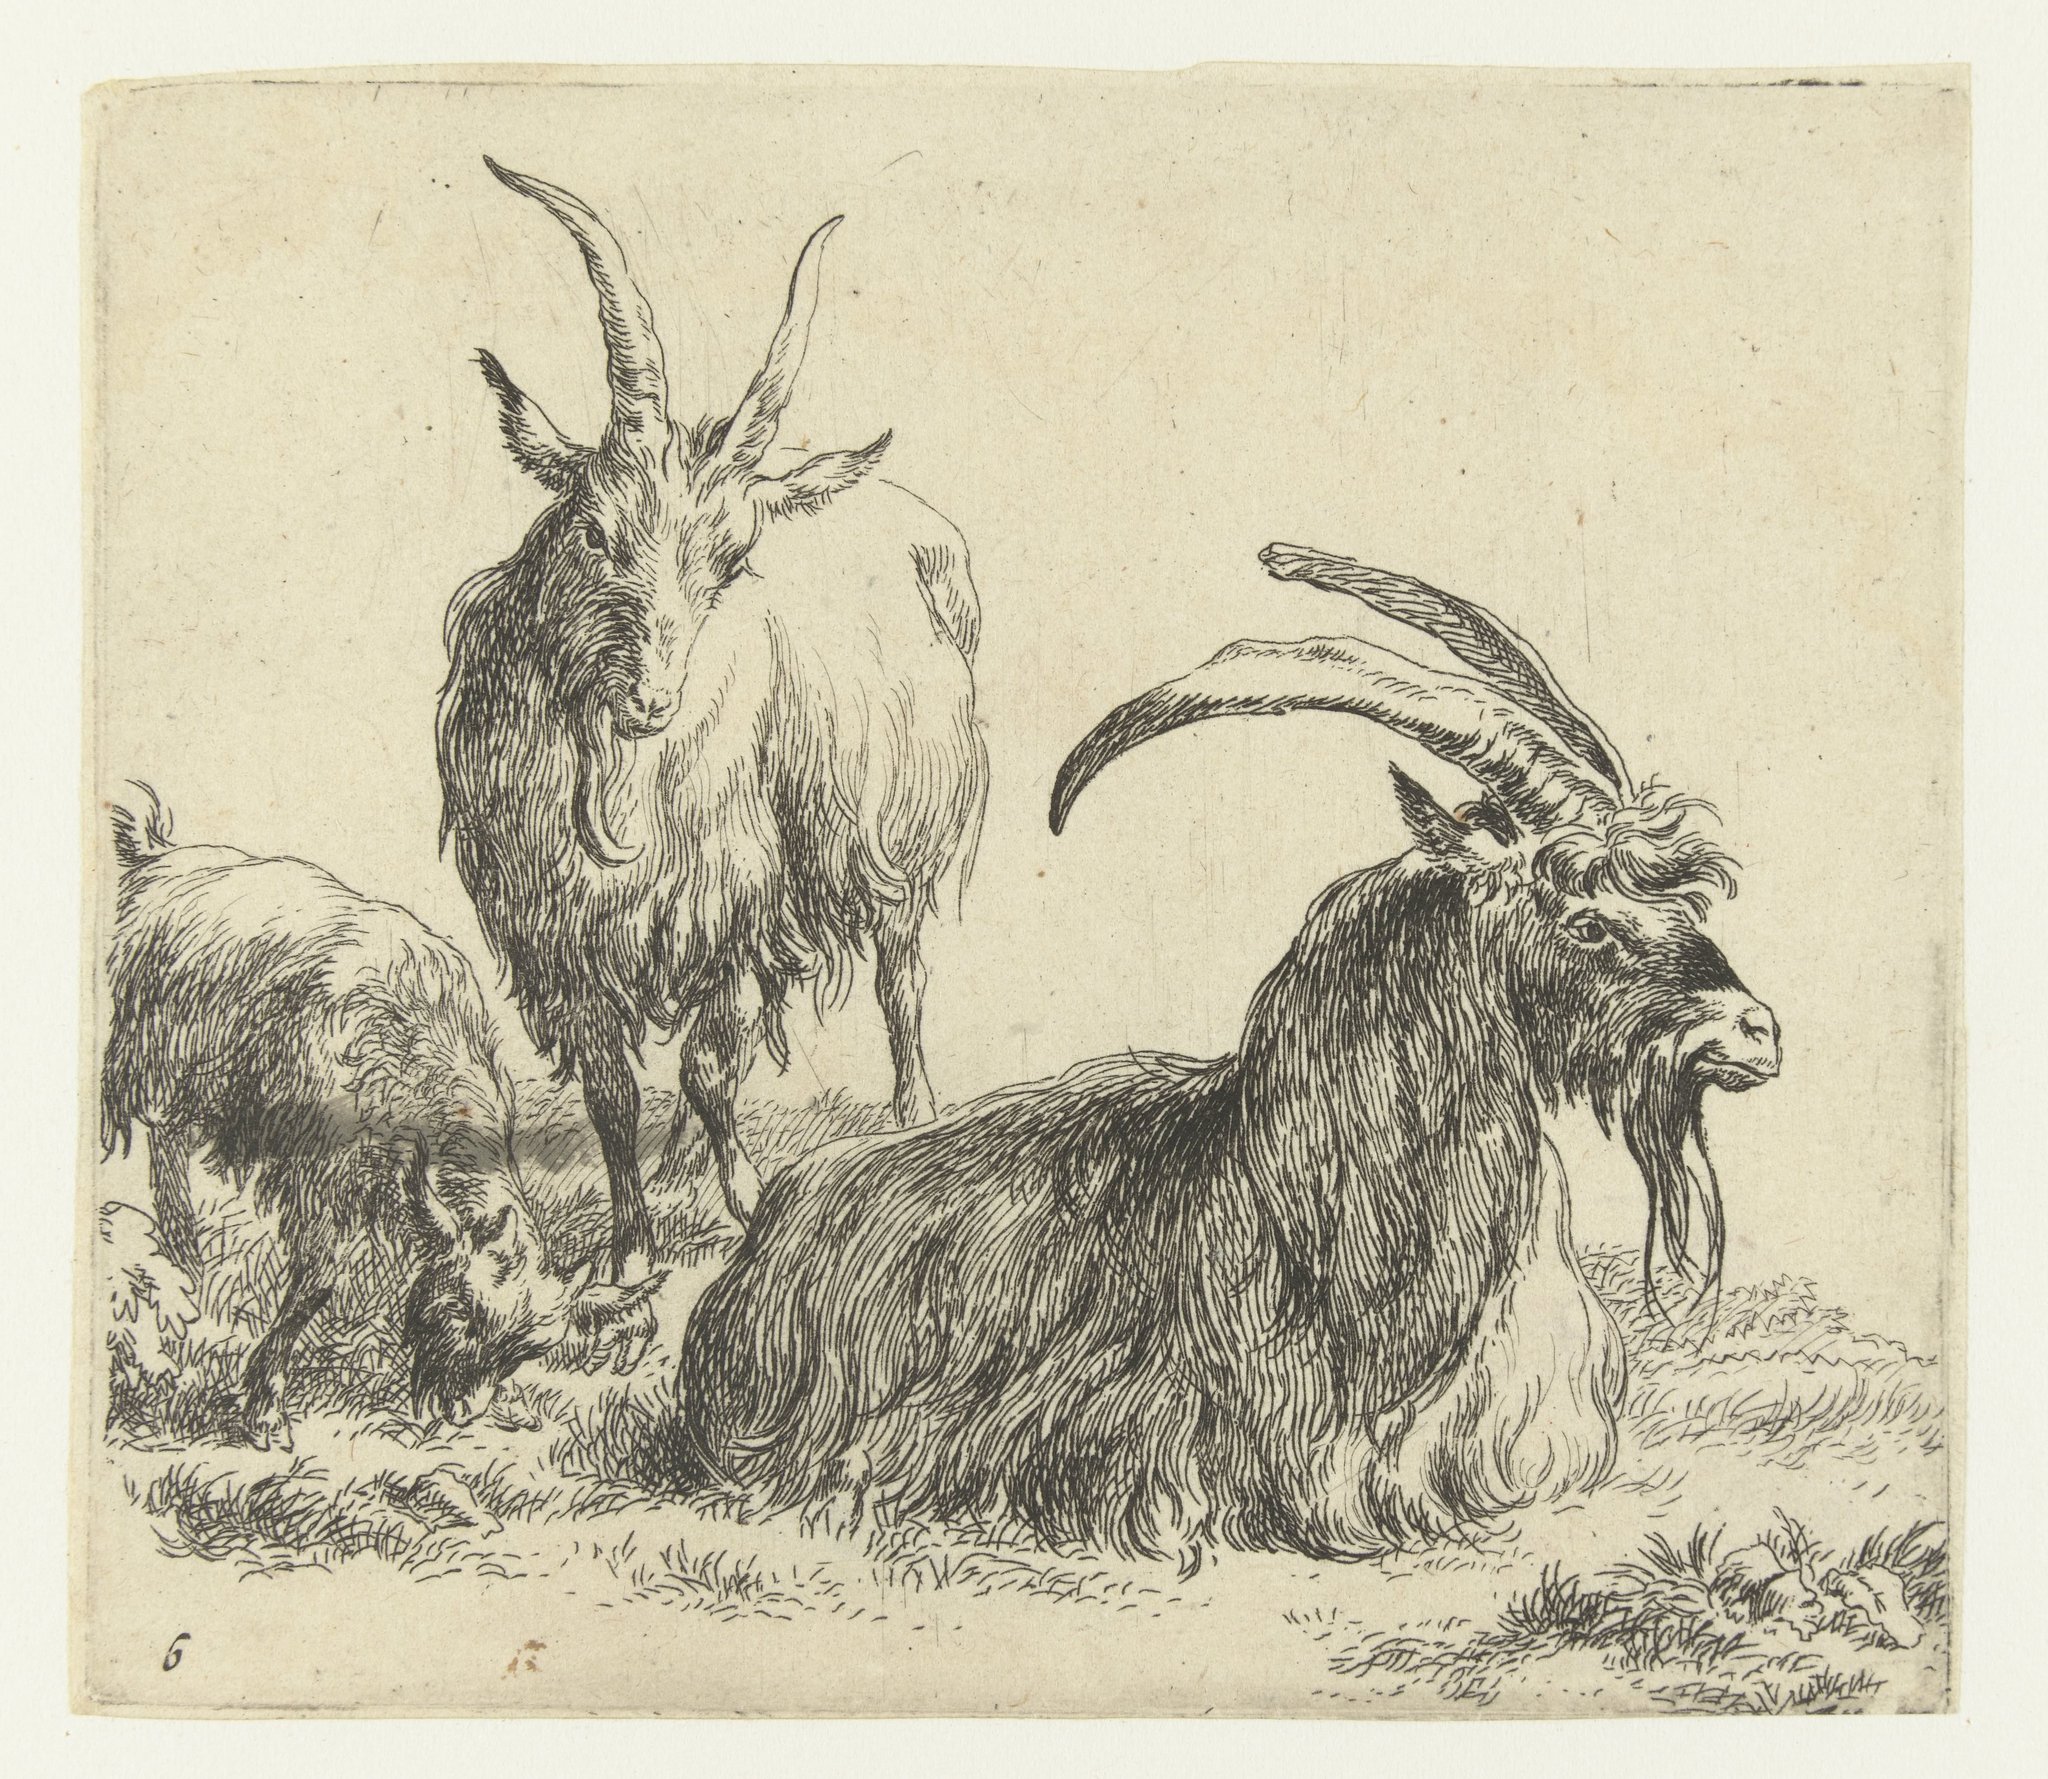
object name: print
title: Verschillende dieren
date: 1648-1652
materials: paper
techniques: etching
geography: netherlands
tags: goat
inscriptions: collector's mark: Lugt 240